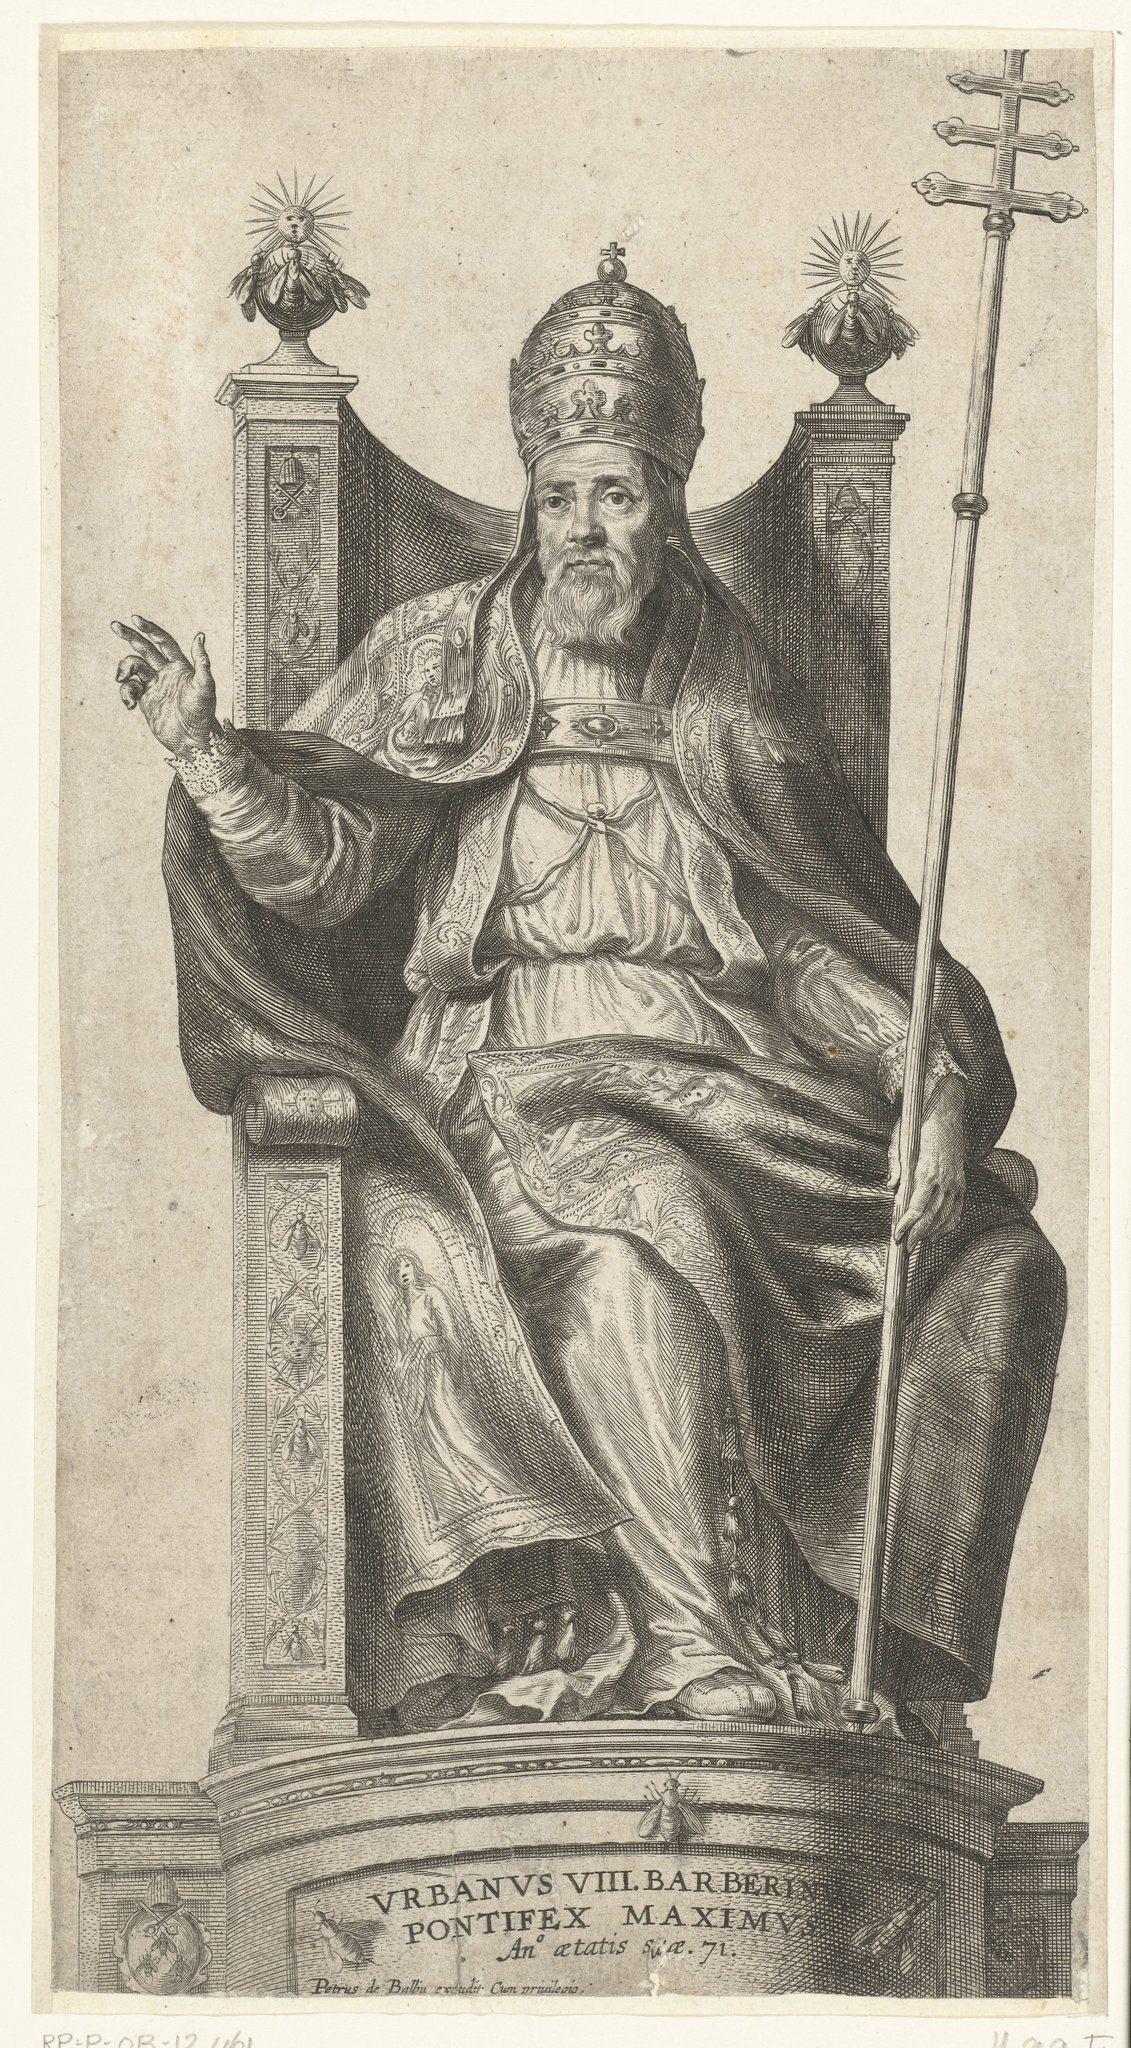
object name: print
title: Portret van paus Urbanus VIII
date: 1623-1660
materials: paper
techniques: engraving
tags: rome, clergyman, urbanus viii, insignia of the pope, e.g. tiara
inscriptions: collector's mark: Lugt 2228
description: Portret van paus Urbanus VIII op 71-jarige leeftijd.